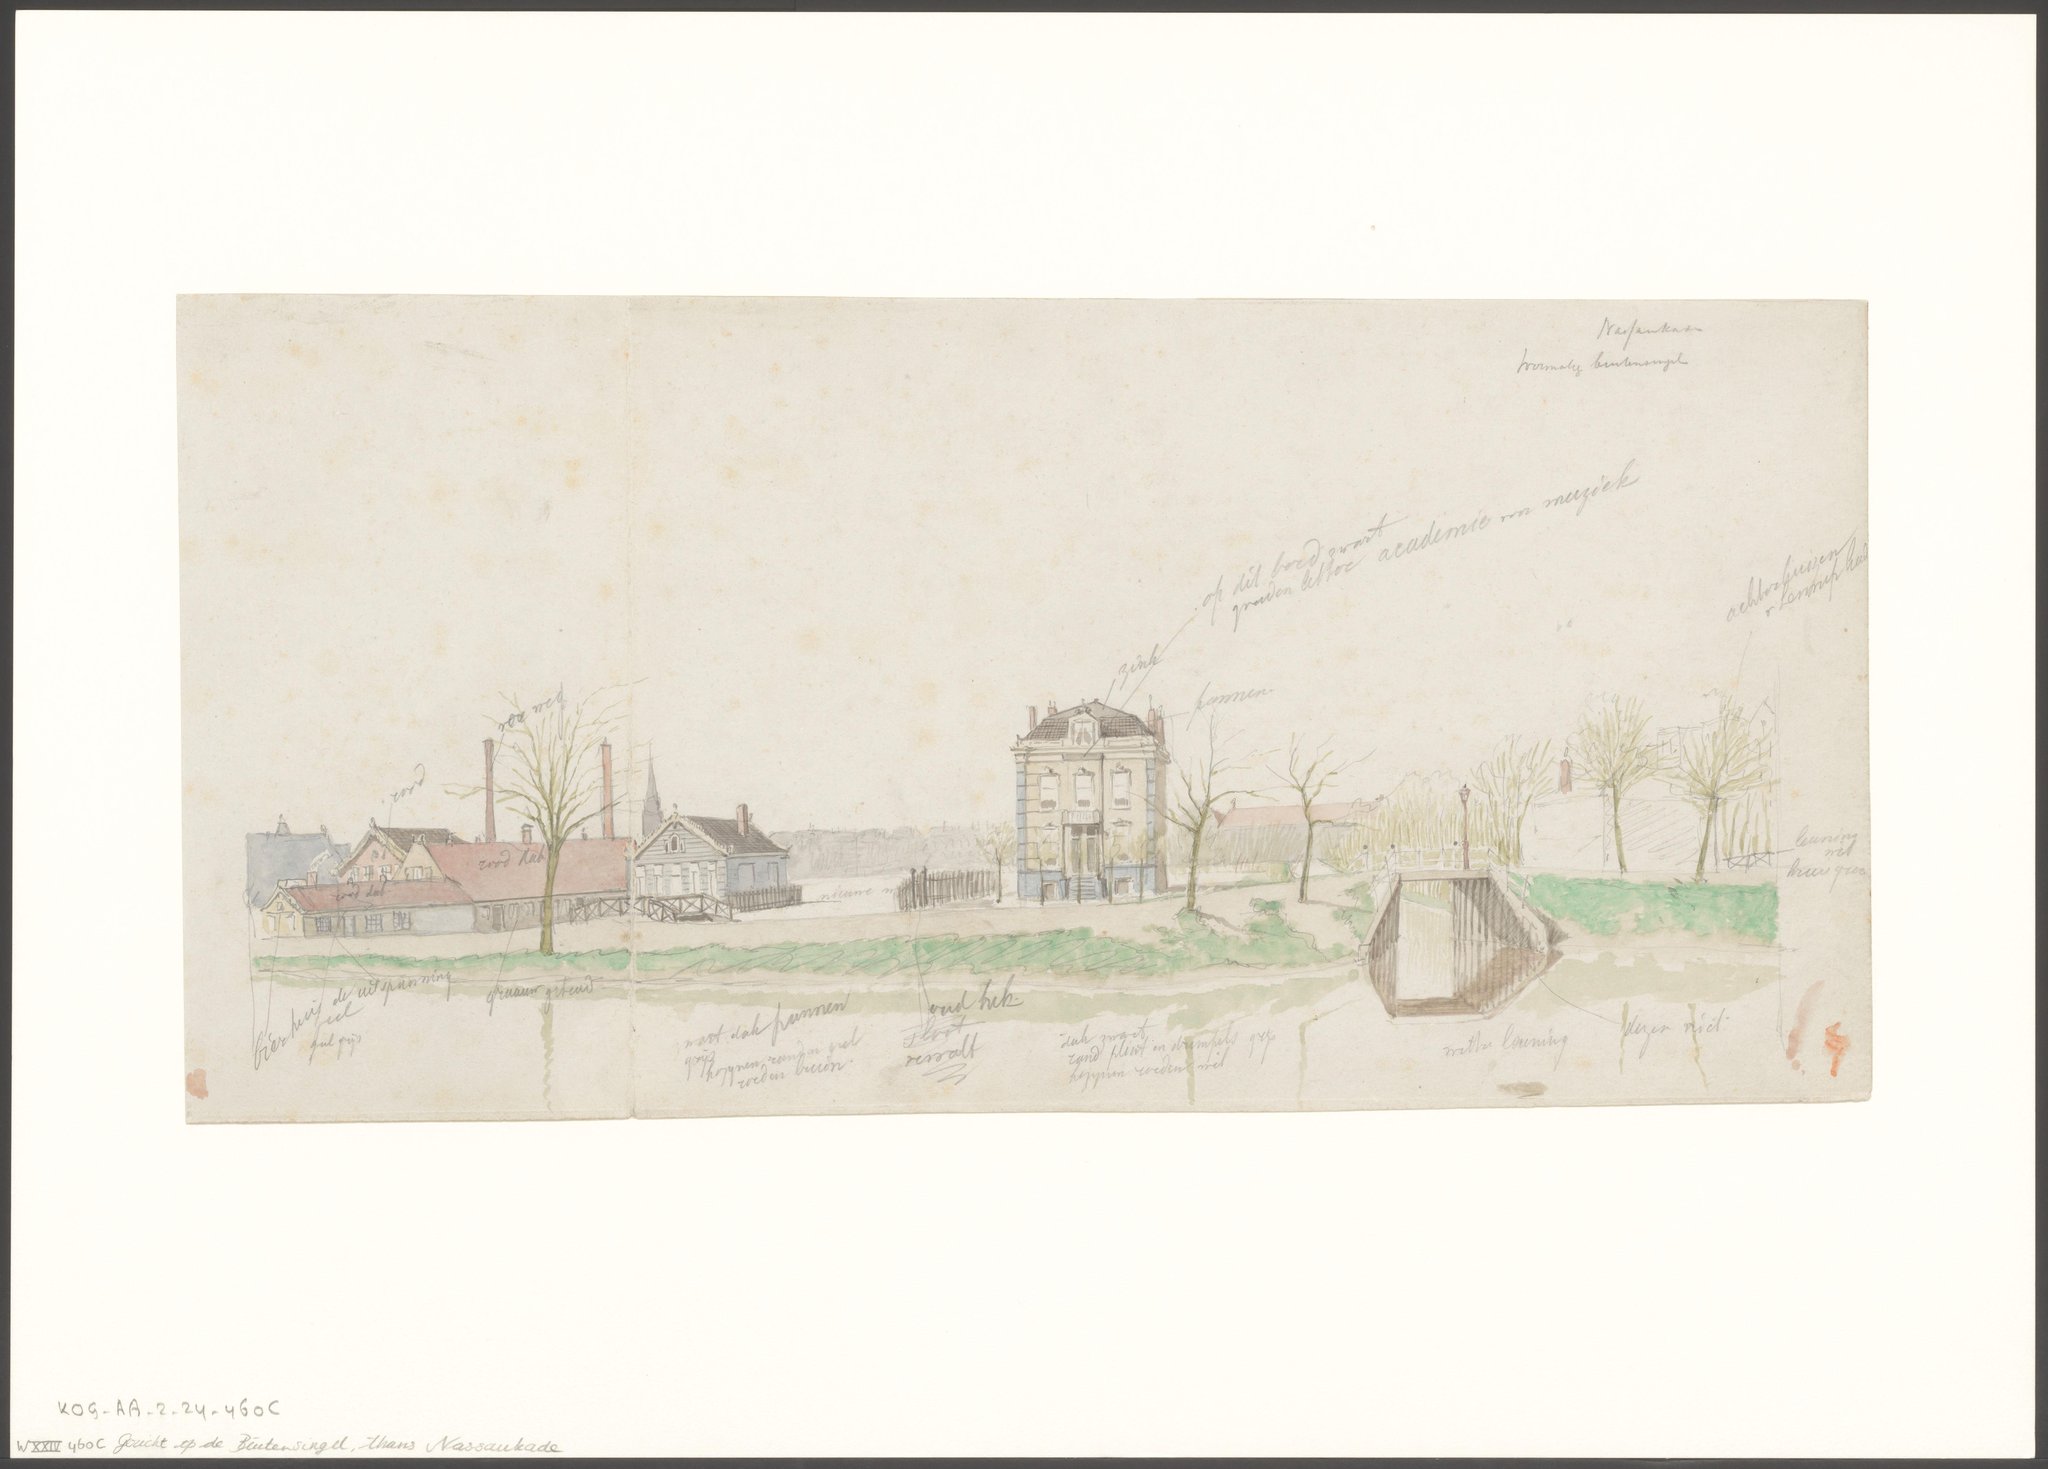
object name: drawing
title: Gezicht op de Nassaukade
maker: johan martinus anthon rieke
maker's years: 1851-1899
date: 1861-1899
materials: paper, pencil, watercolor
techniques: brush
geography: amsterdam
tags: city-view in general; 'veduta', canal, façade (of house or building), bridge in city across river, canal, etc.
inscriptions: collector's mark: Lugt 800a, inscription: ‘Nassaukade / voormalig buitensingel (...) [...]ming dezen niet’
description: Tekening binnen de Atlas Van Eck ingedeeld op wijknummer 24.